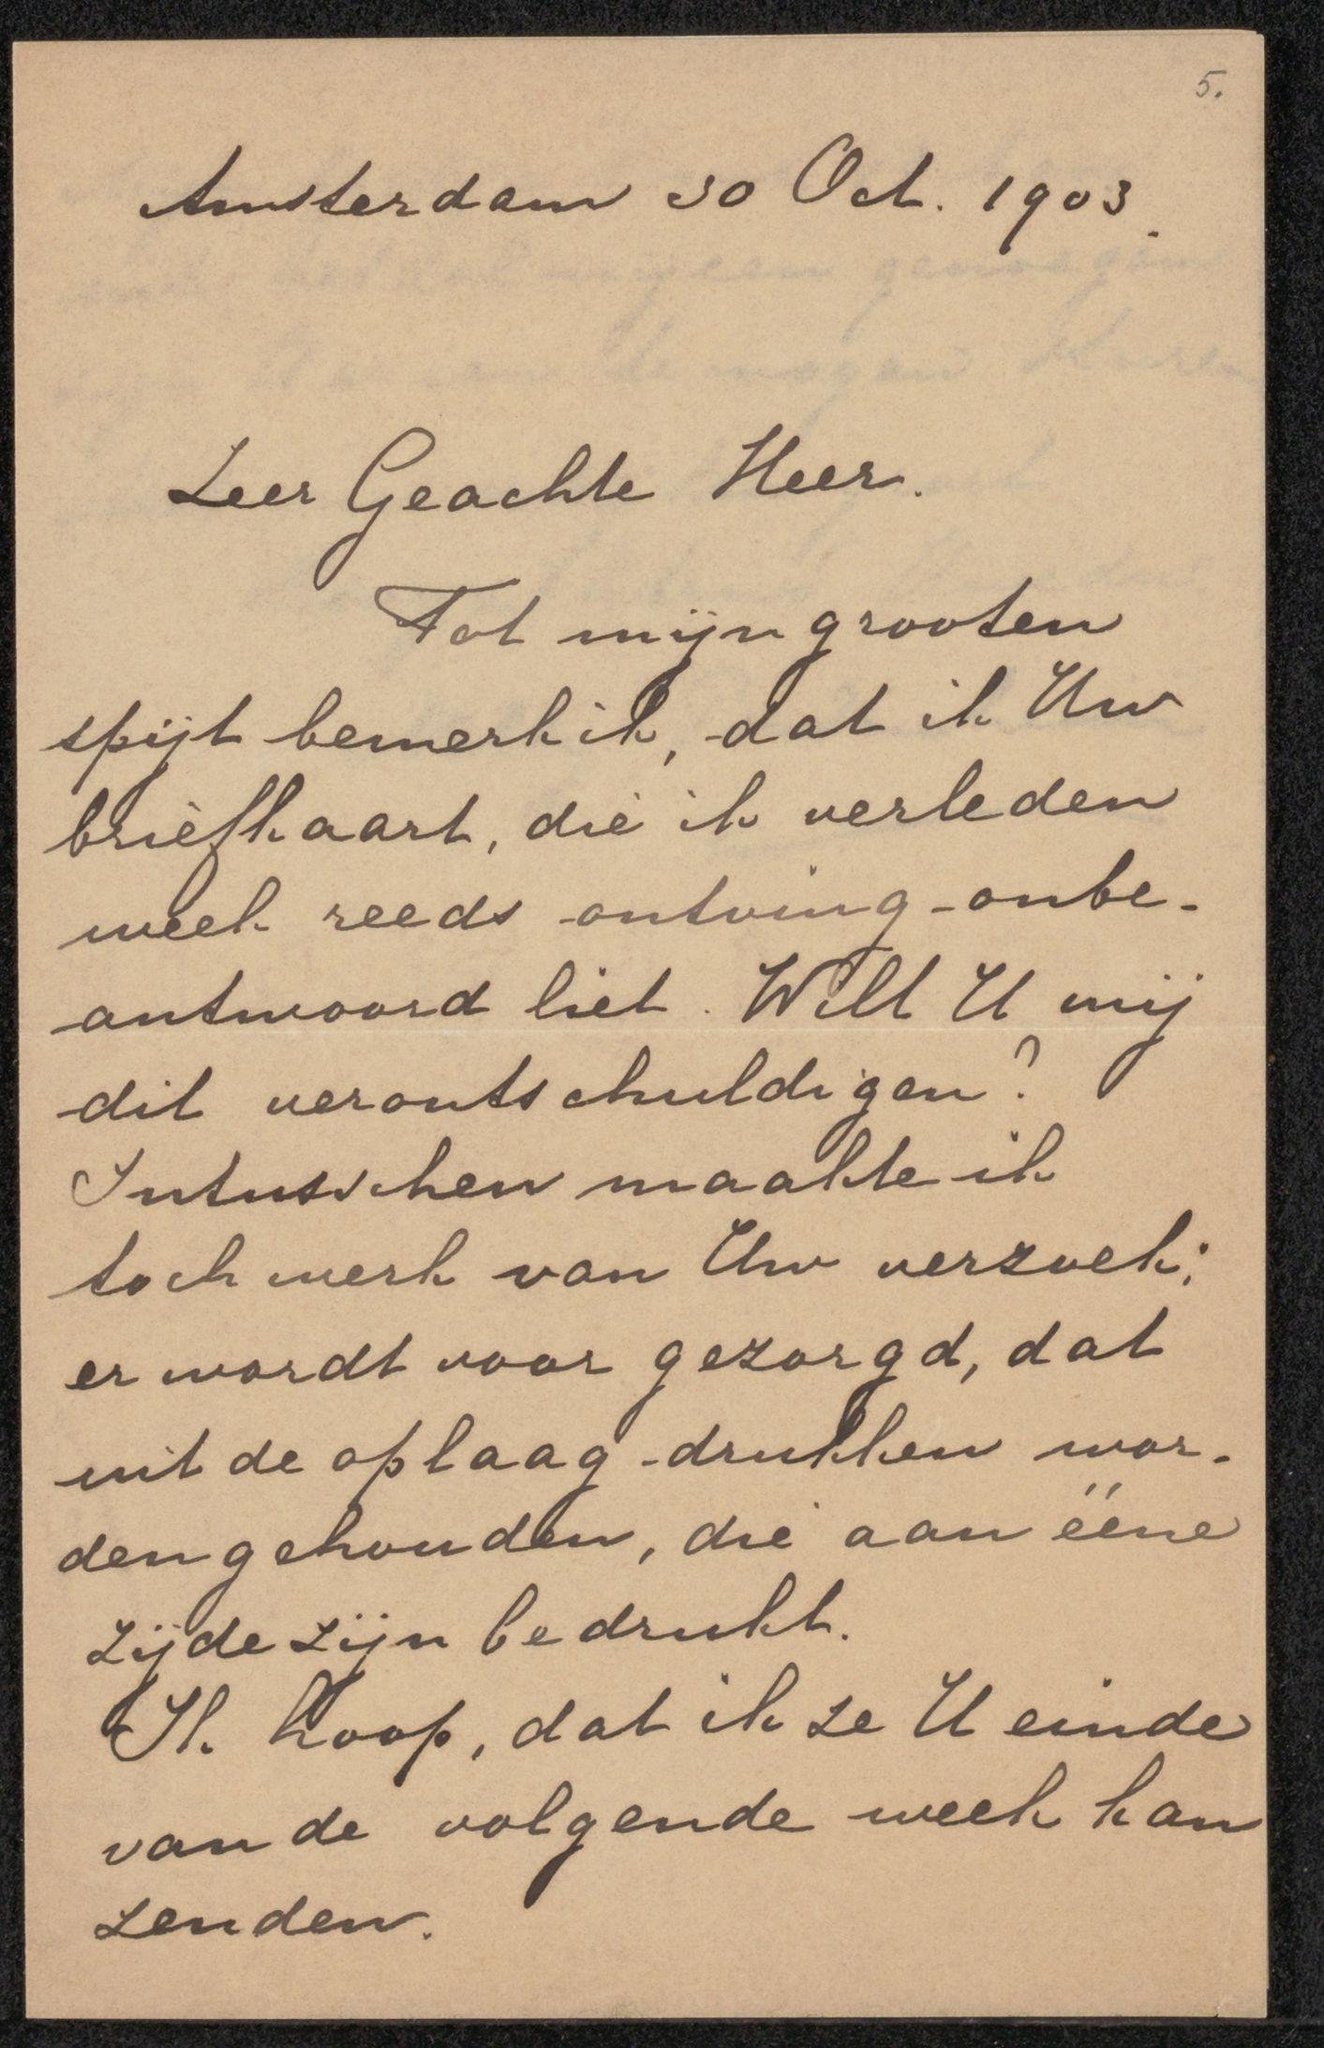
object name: letter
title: Brief aan Pieter Haverkorn van Rijsewijk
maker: nelly bodenheim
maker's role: designer, draughtsman, print maker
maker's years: 1874-1951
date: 1903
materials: ink, paper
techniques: pen, writing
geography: amsterdam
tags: pieter haverkorn van rijsewijk, printed matter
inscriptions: watermark, collector's mark: ‘RPK’